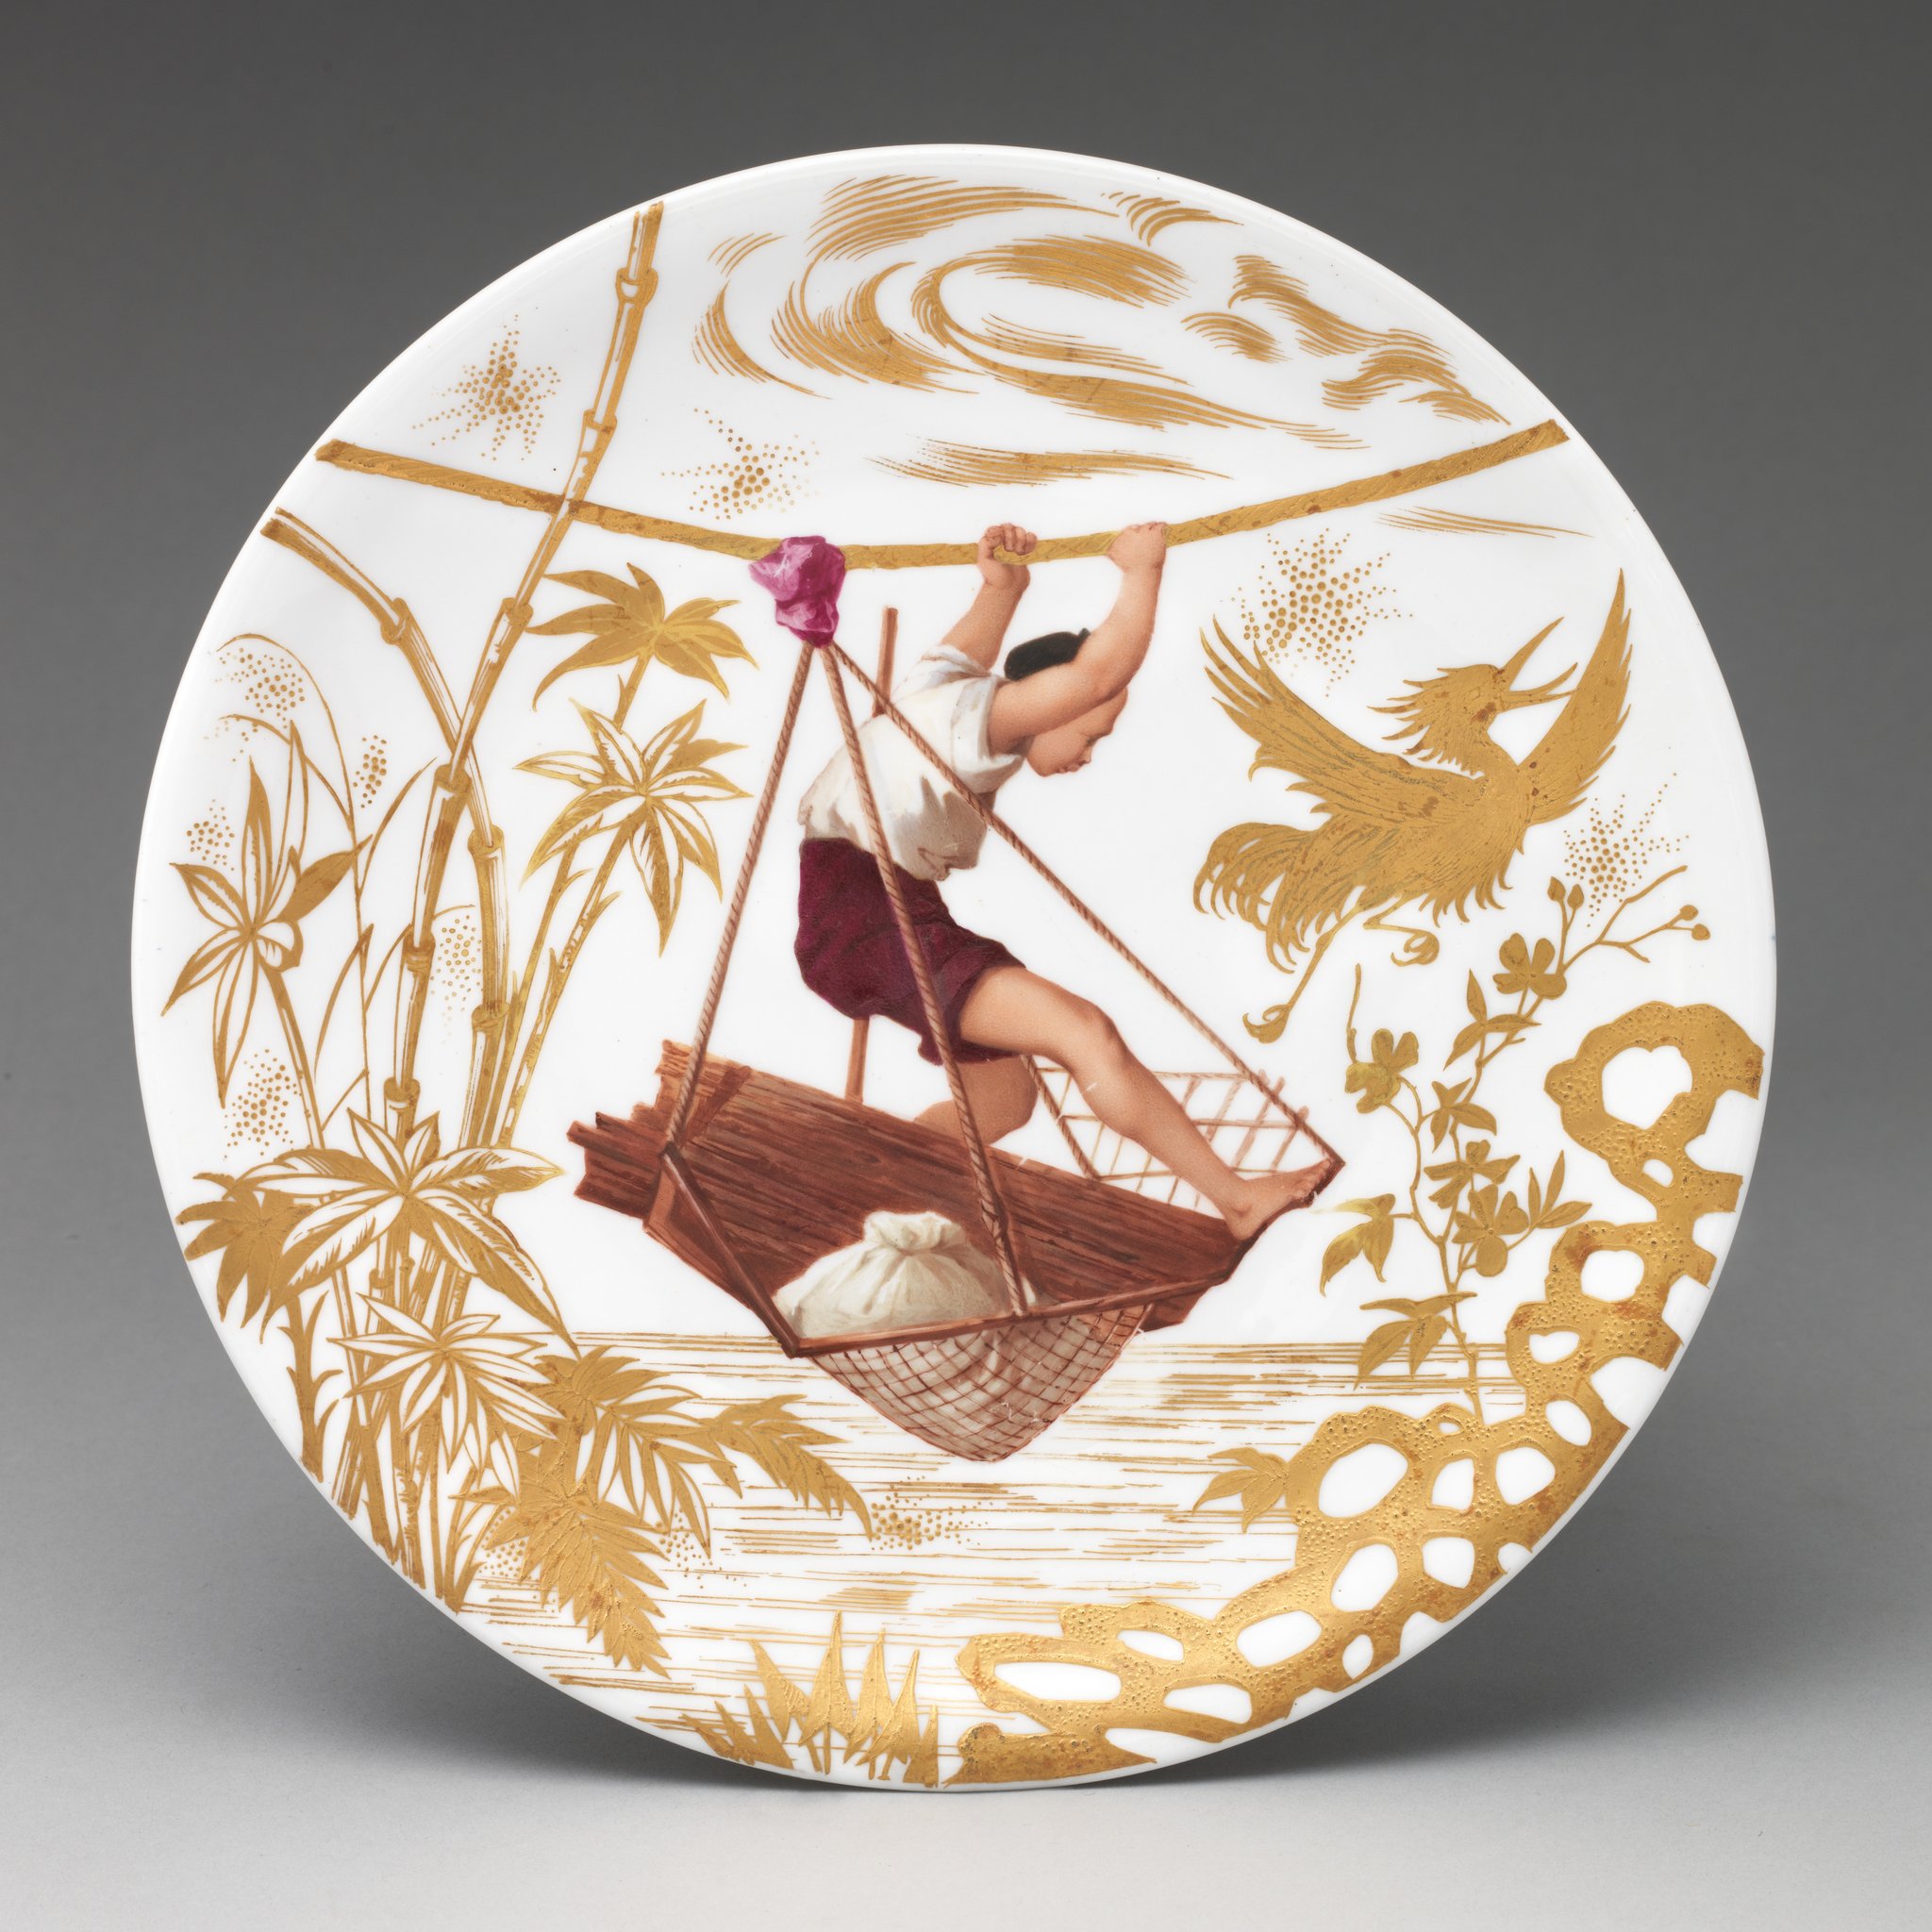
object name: plate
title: Le Bac Aerien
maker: worcester factory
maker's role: factory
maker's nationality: british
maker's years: 1751-2008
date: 1880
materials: bone china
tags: birds,men